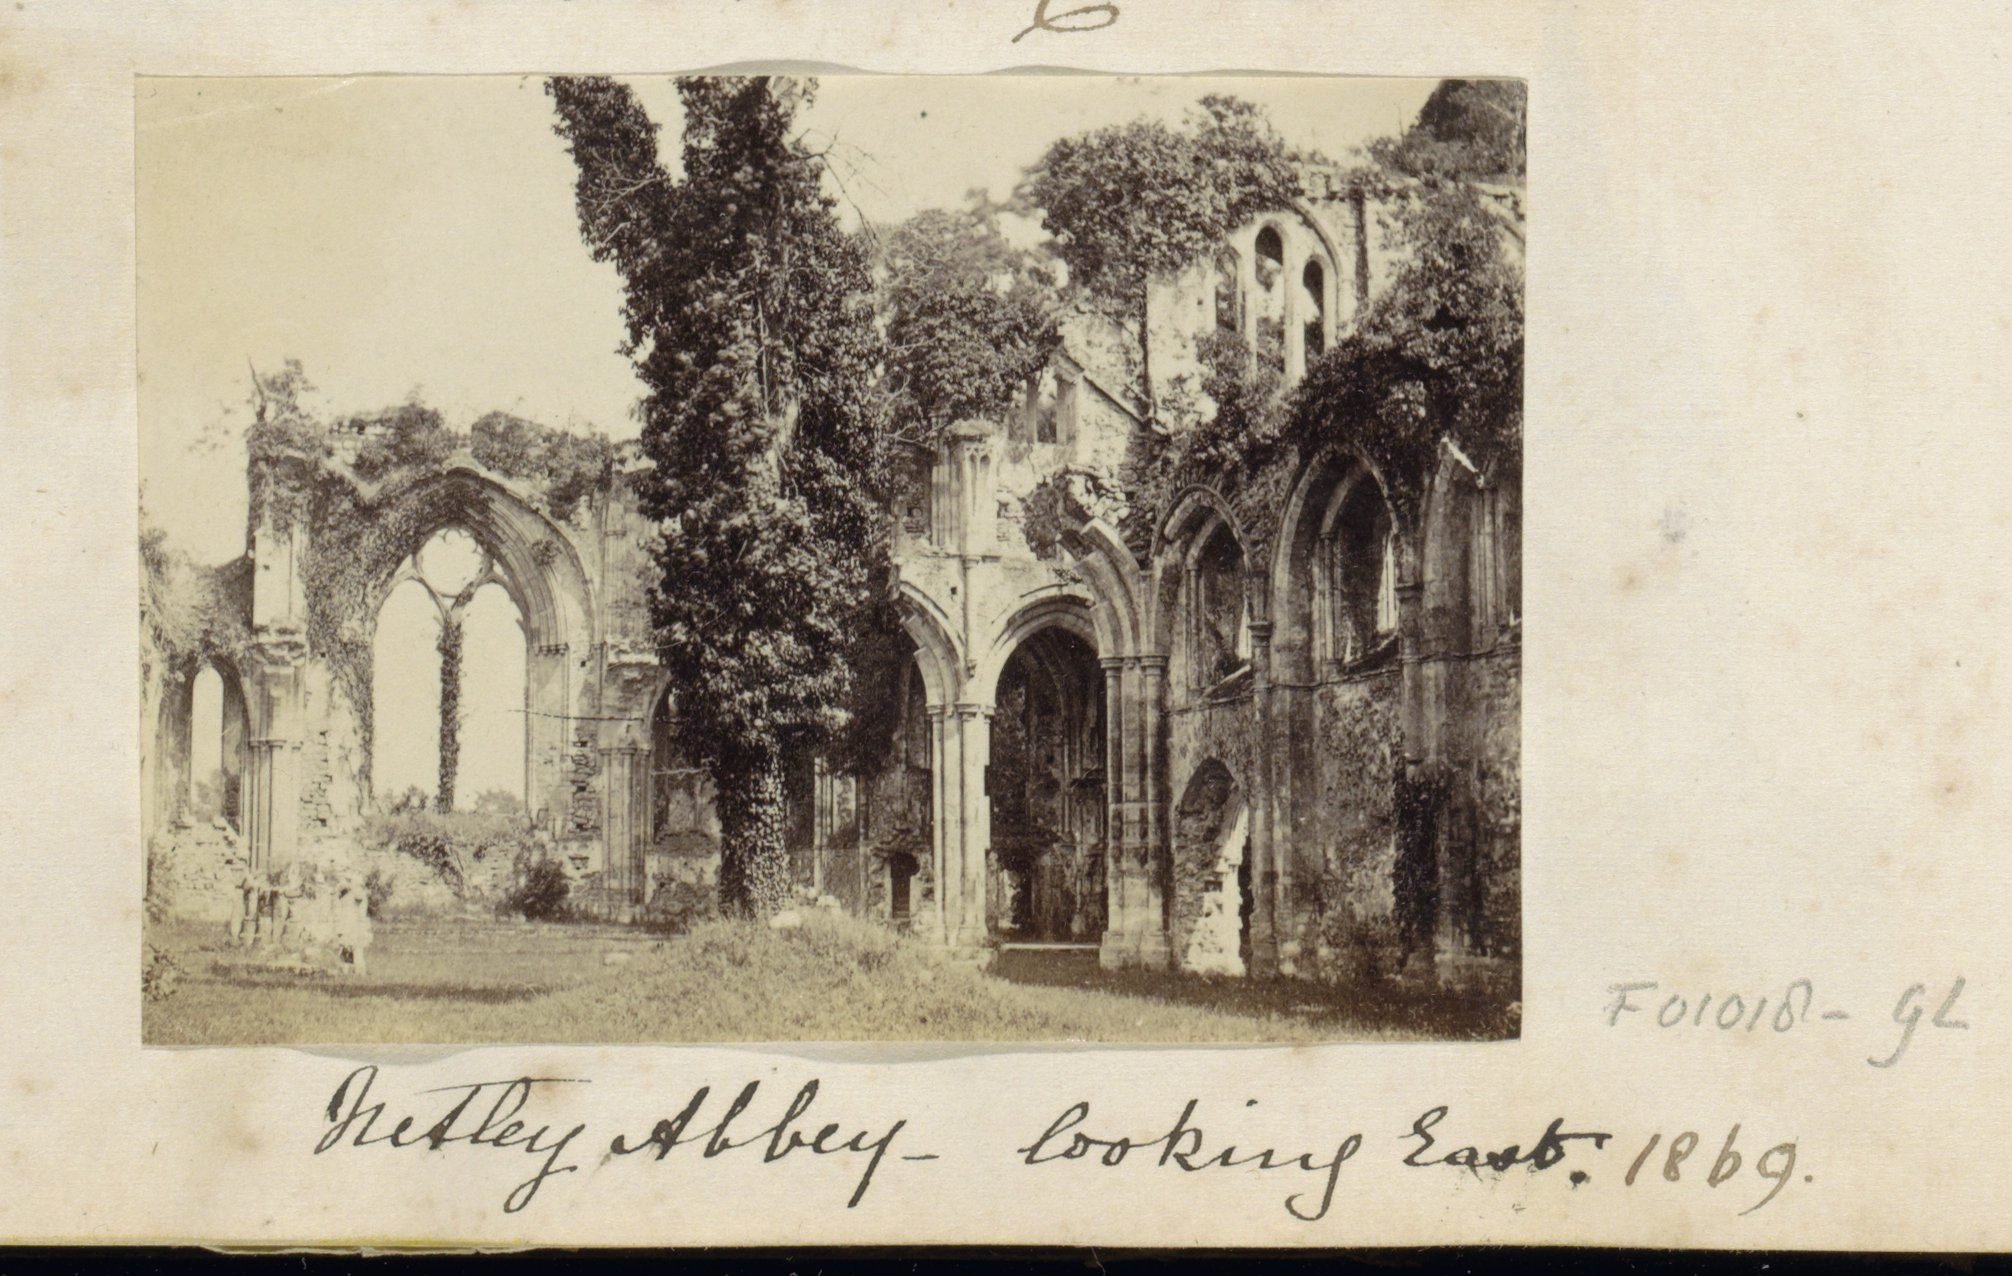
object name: photograph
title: Ruïne van de abdij van Netley, gezien naar het oosten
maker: Anonymous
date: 1869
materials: paper, photographic support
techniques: albumen print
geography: netley abbey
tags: church-window, e.g. rose-window, arch, archivolt ~ architecture, abbey, monastery, convent ~ roman catholic church, ruin of a dwelling, house, castle, etc.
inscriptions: date: ‘1869’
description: Onderdeel van Engels familiealbum met foto's van personen, reizen, cricket en kunstwerken.